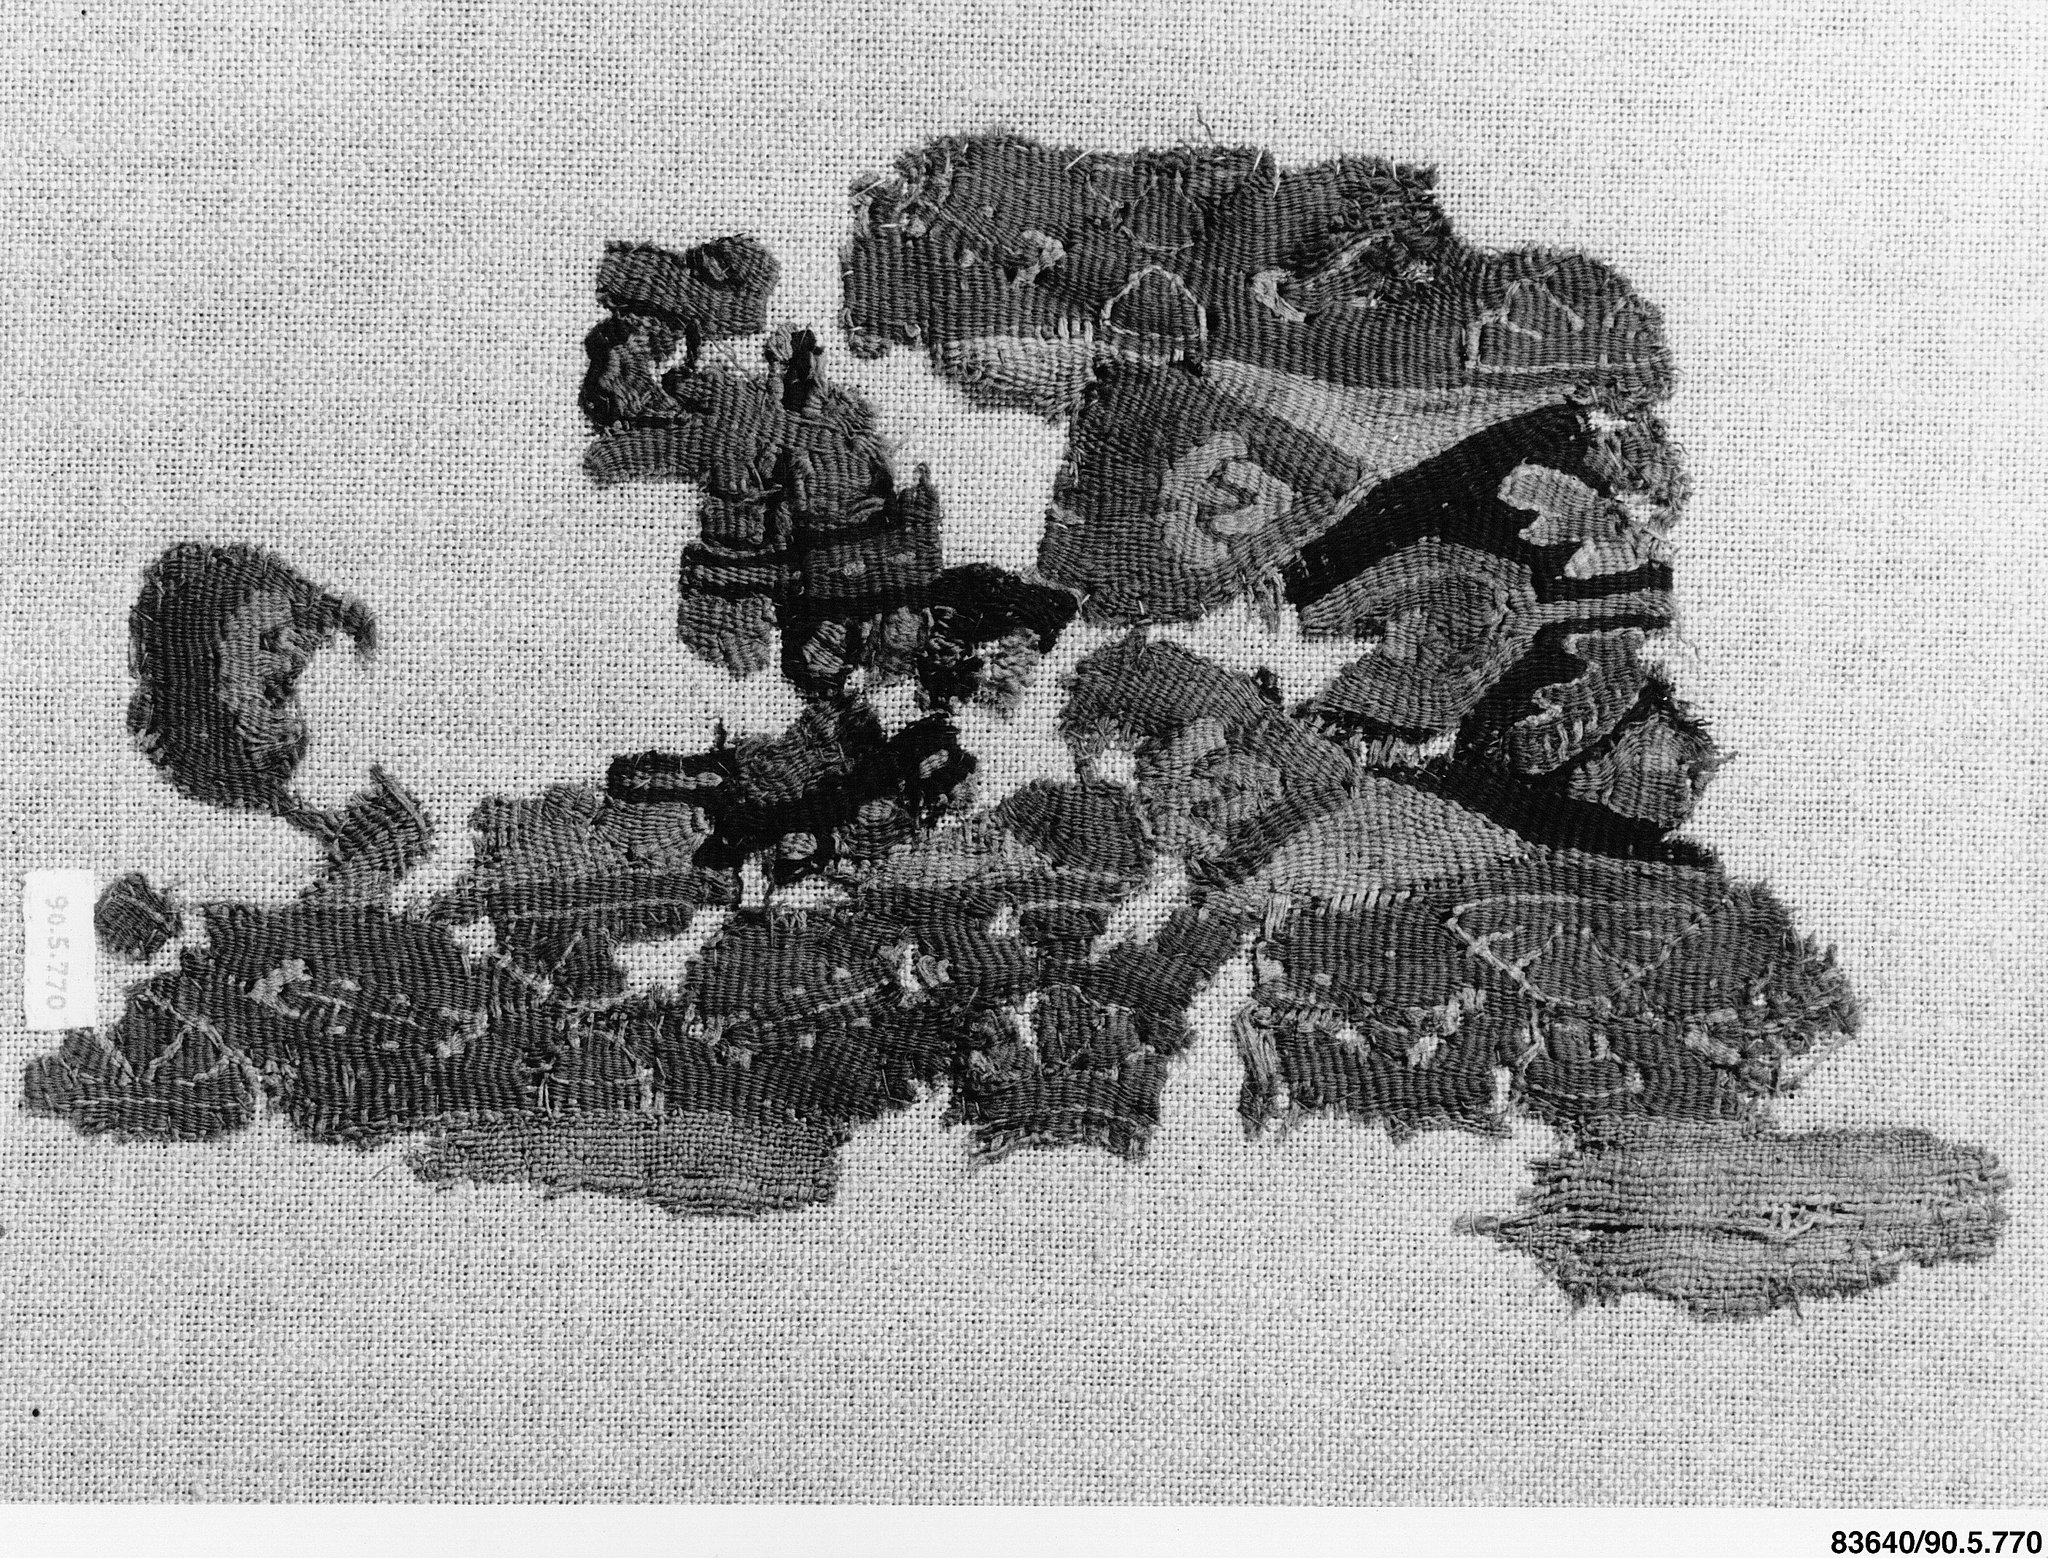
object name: textile fragment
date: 401-600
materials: linen, wool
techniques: weave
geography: egypt